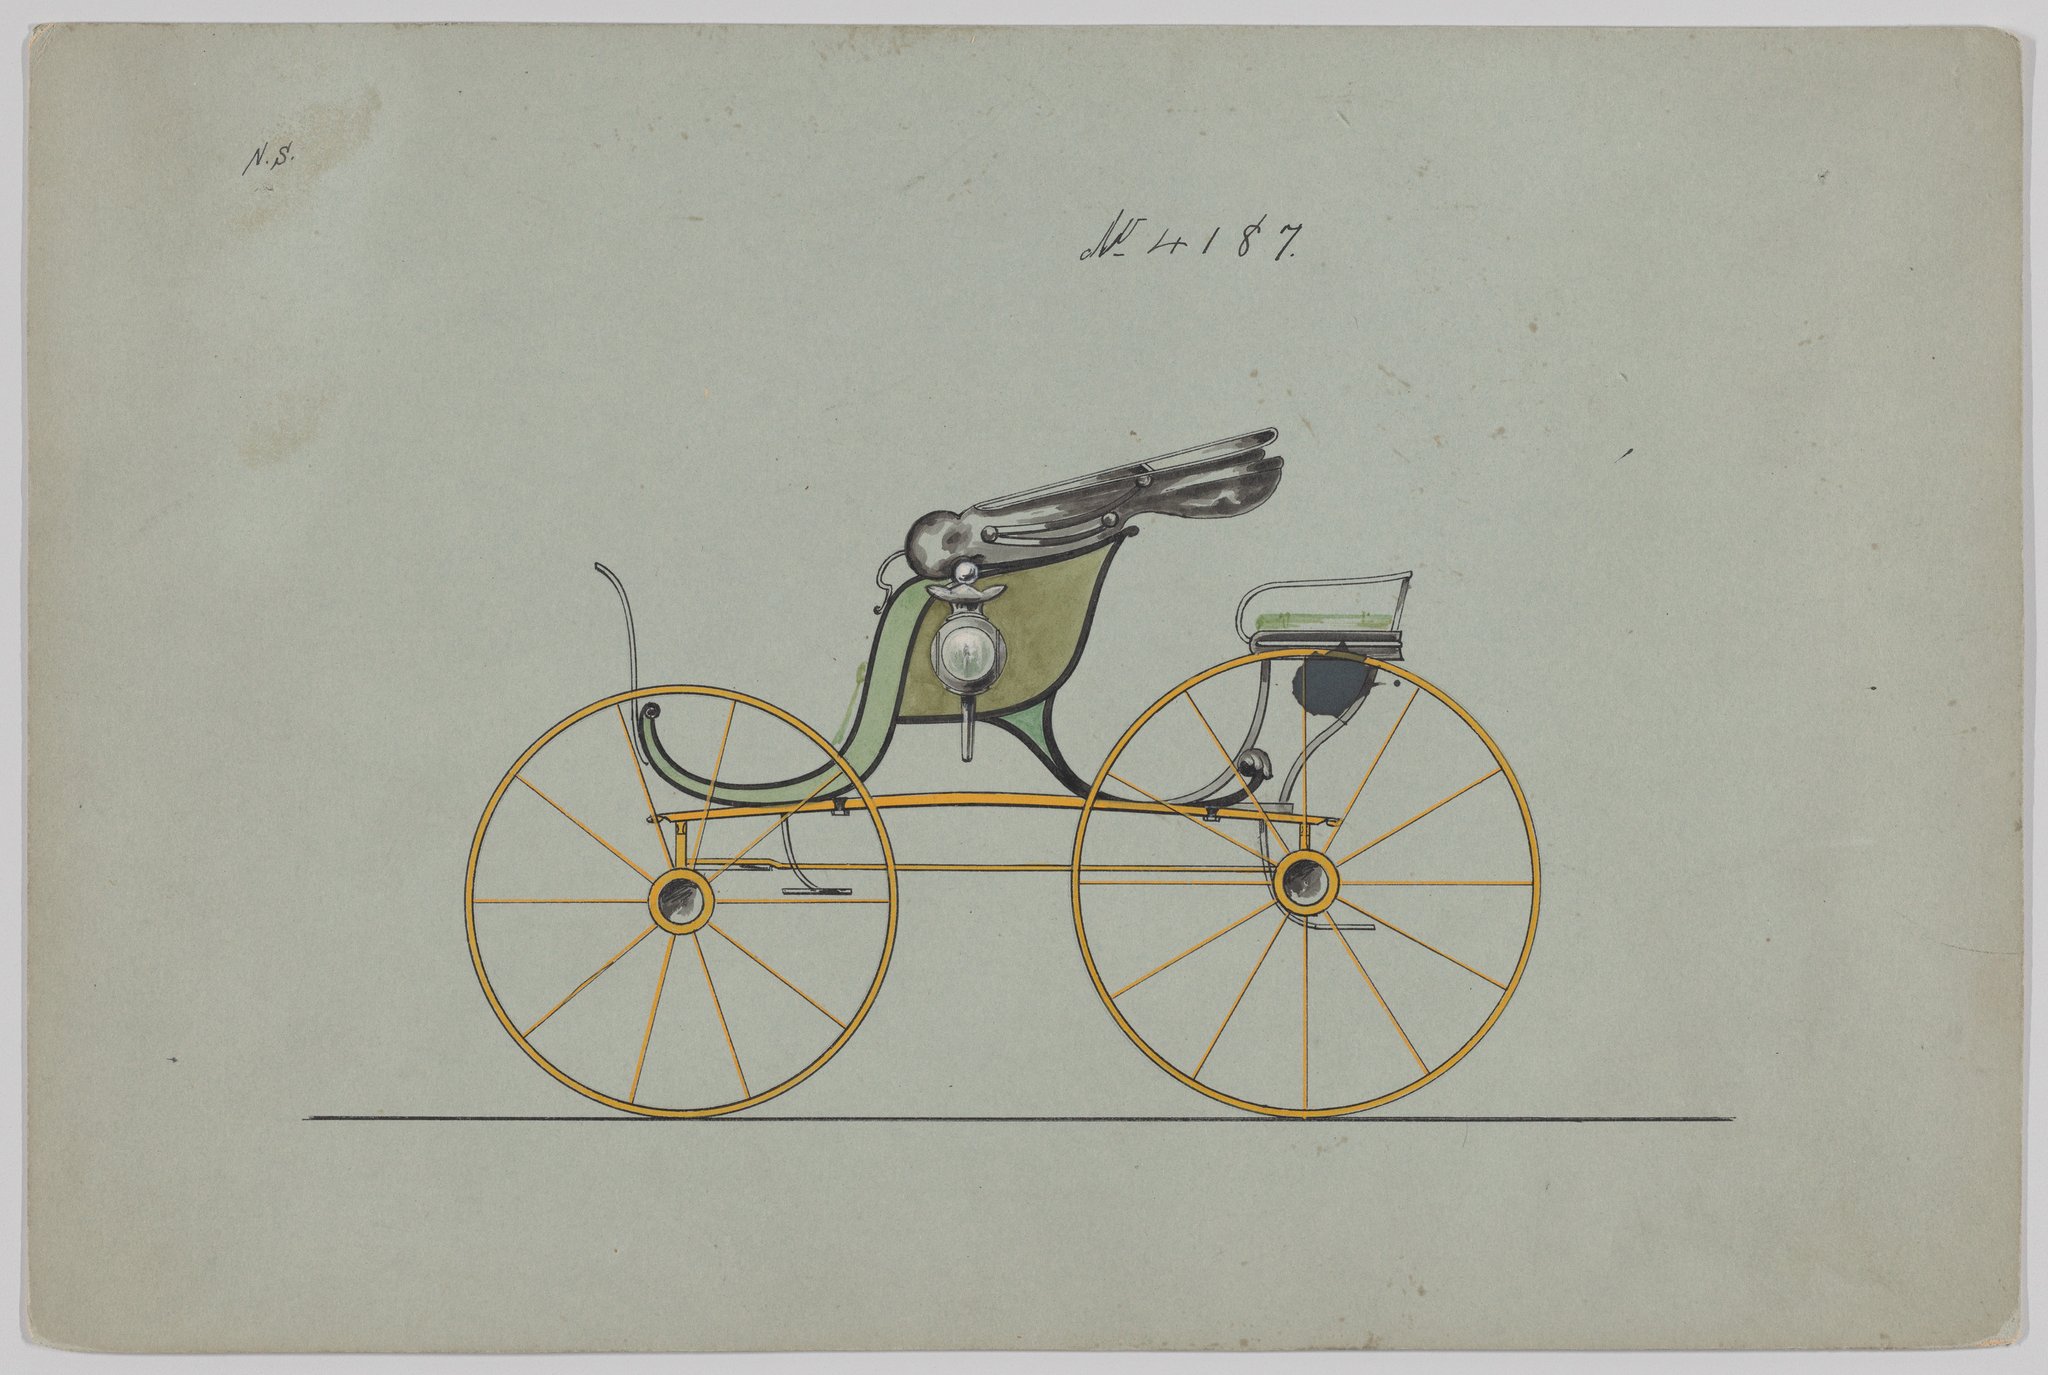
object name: drawing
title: Design for Pony Phaeton, no. 4187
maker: brewster & co.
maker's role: manufacturer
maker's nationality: american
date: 1892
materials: gouache, ink, watercolor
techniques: pen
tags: carriages